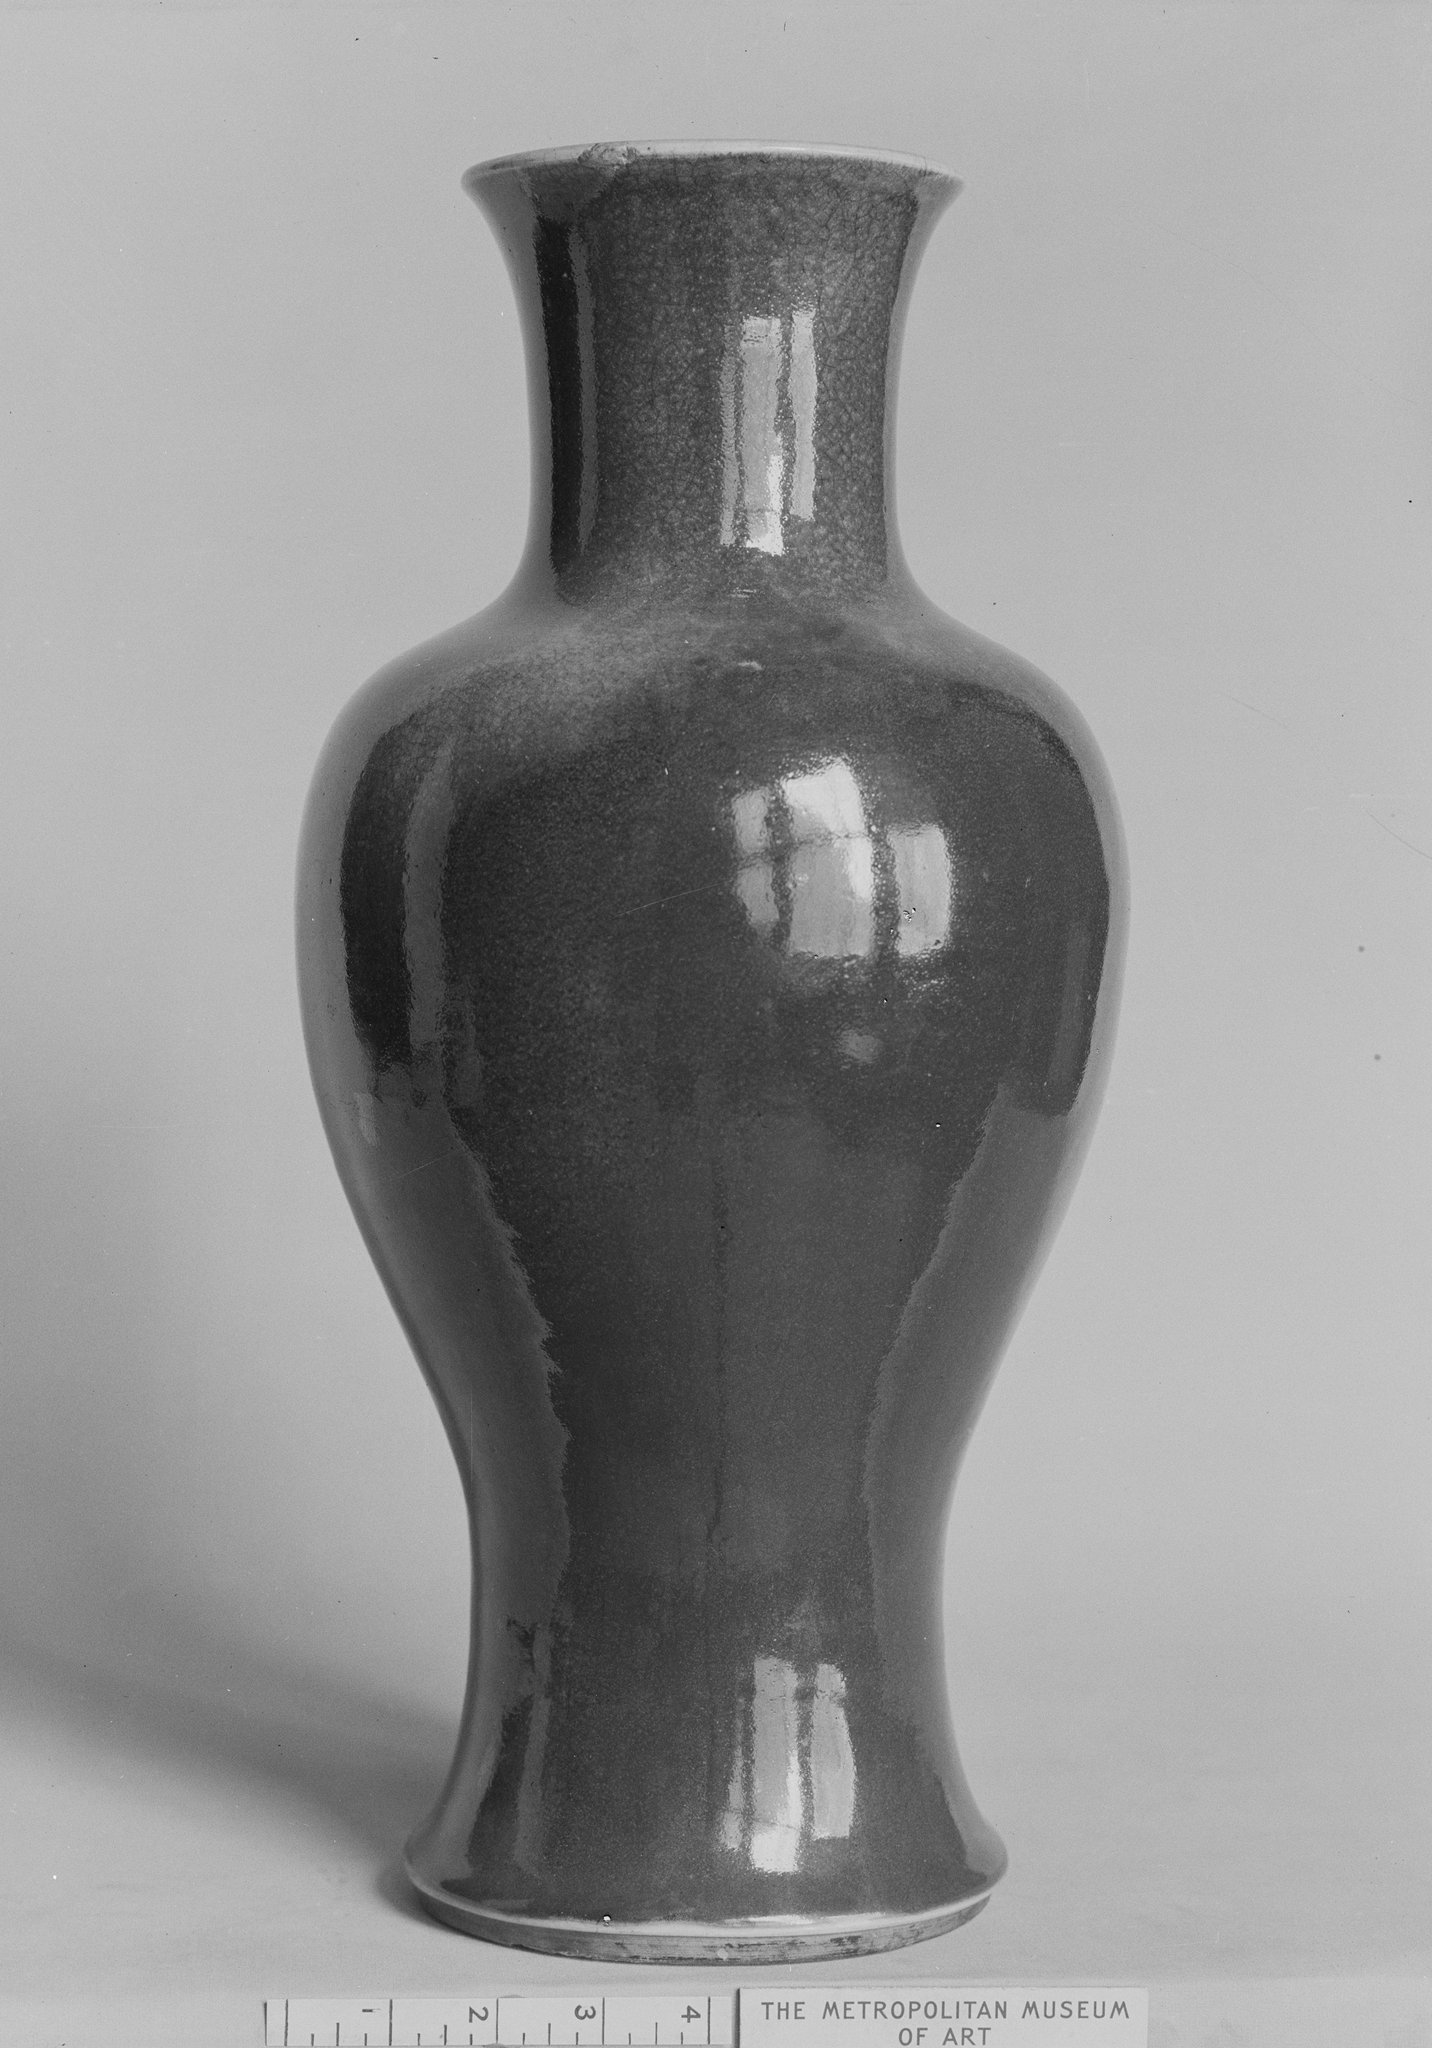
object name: vase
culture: chinese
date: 1662-1722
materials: enamel, porcelain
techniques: painting